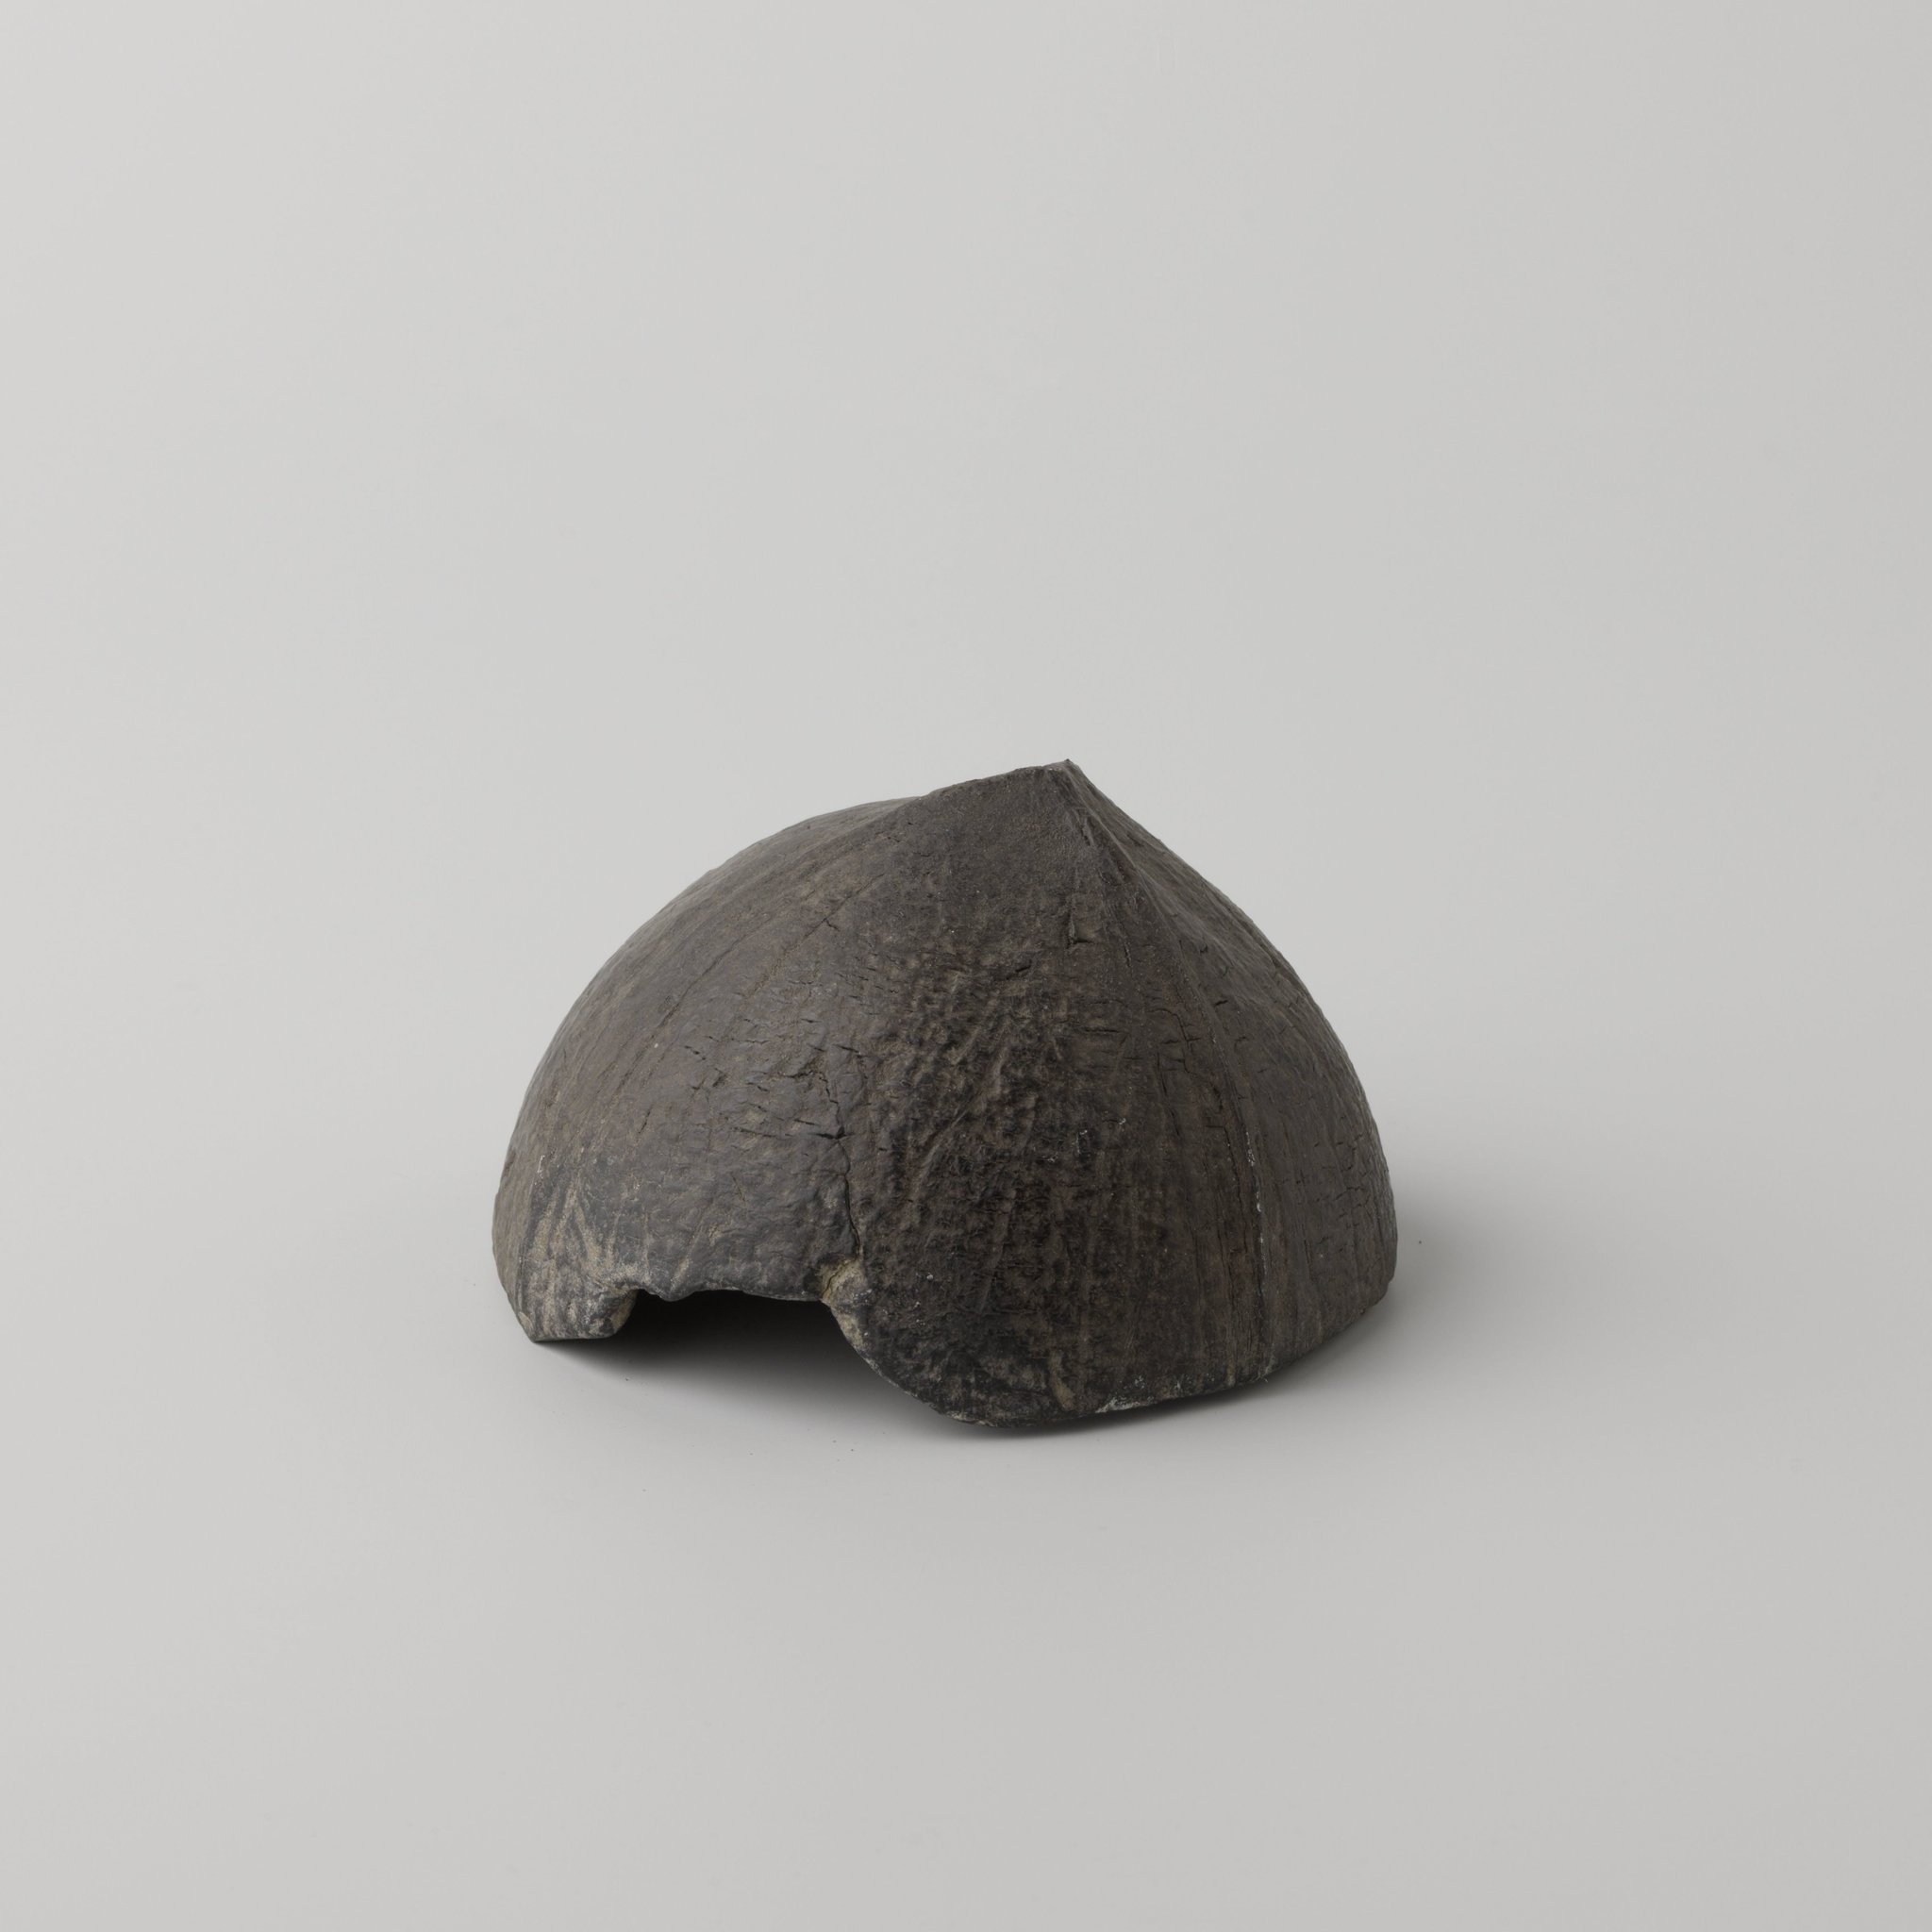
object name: coconut fruit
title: Half coconut shell from the wreck of the Dutch East India ship Witte Leeuw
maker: Anonymous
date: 1613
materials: plant material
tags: verenigde oostindische compagnie, sint-helena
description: Halve kokosnoot uit V.O.C.-schip de 'Witte Leeuw'. De bovenzijde.